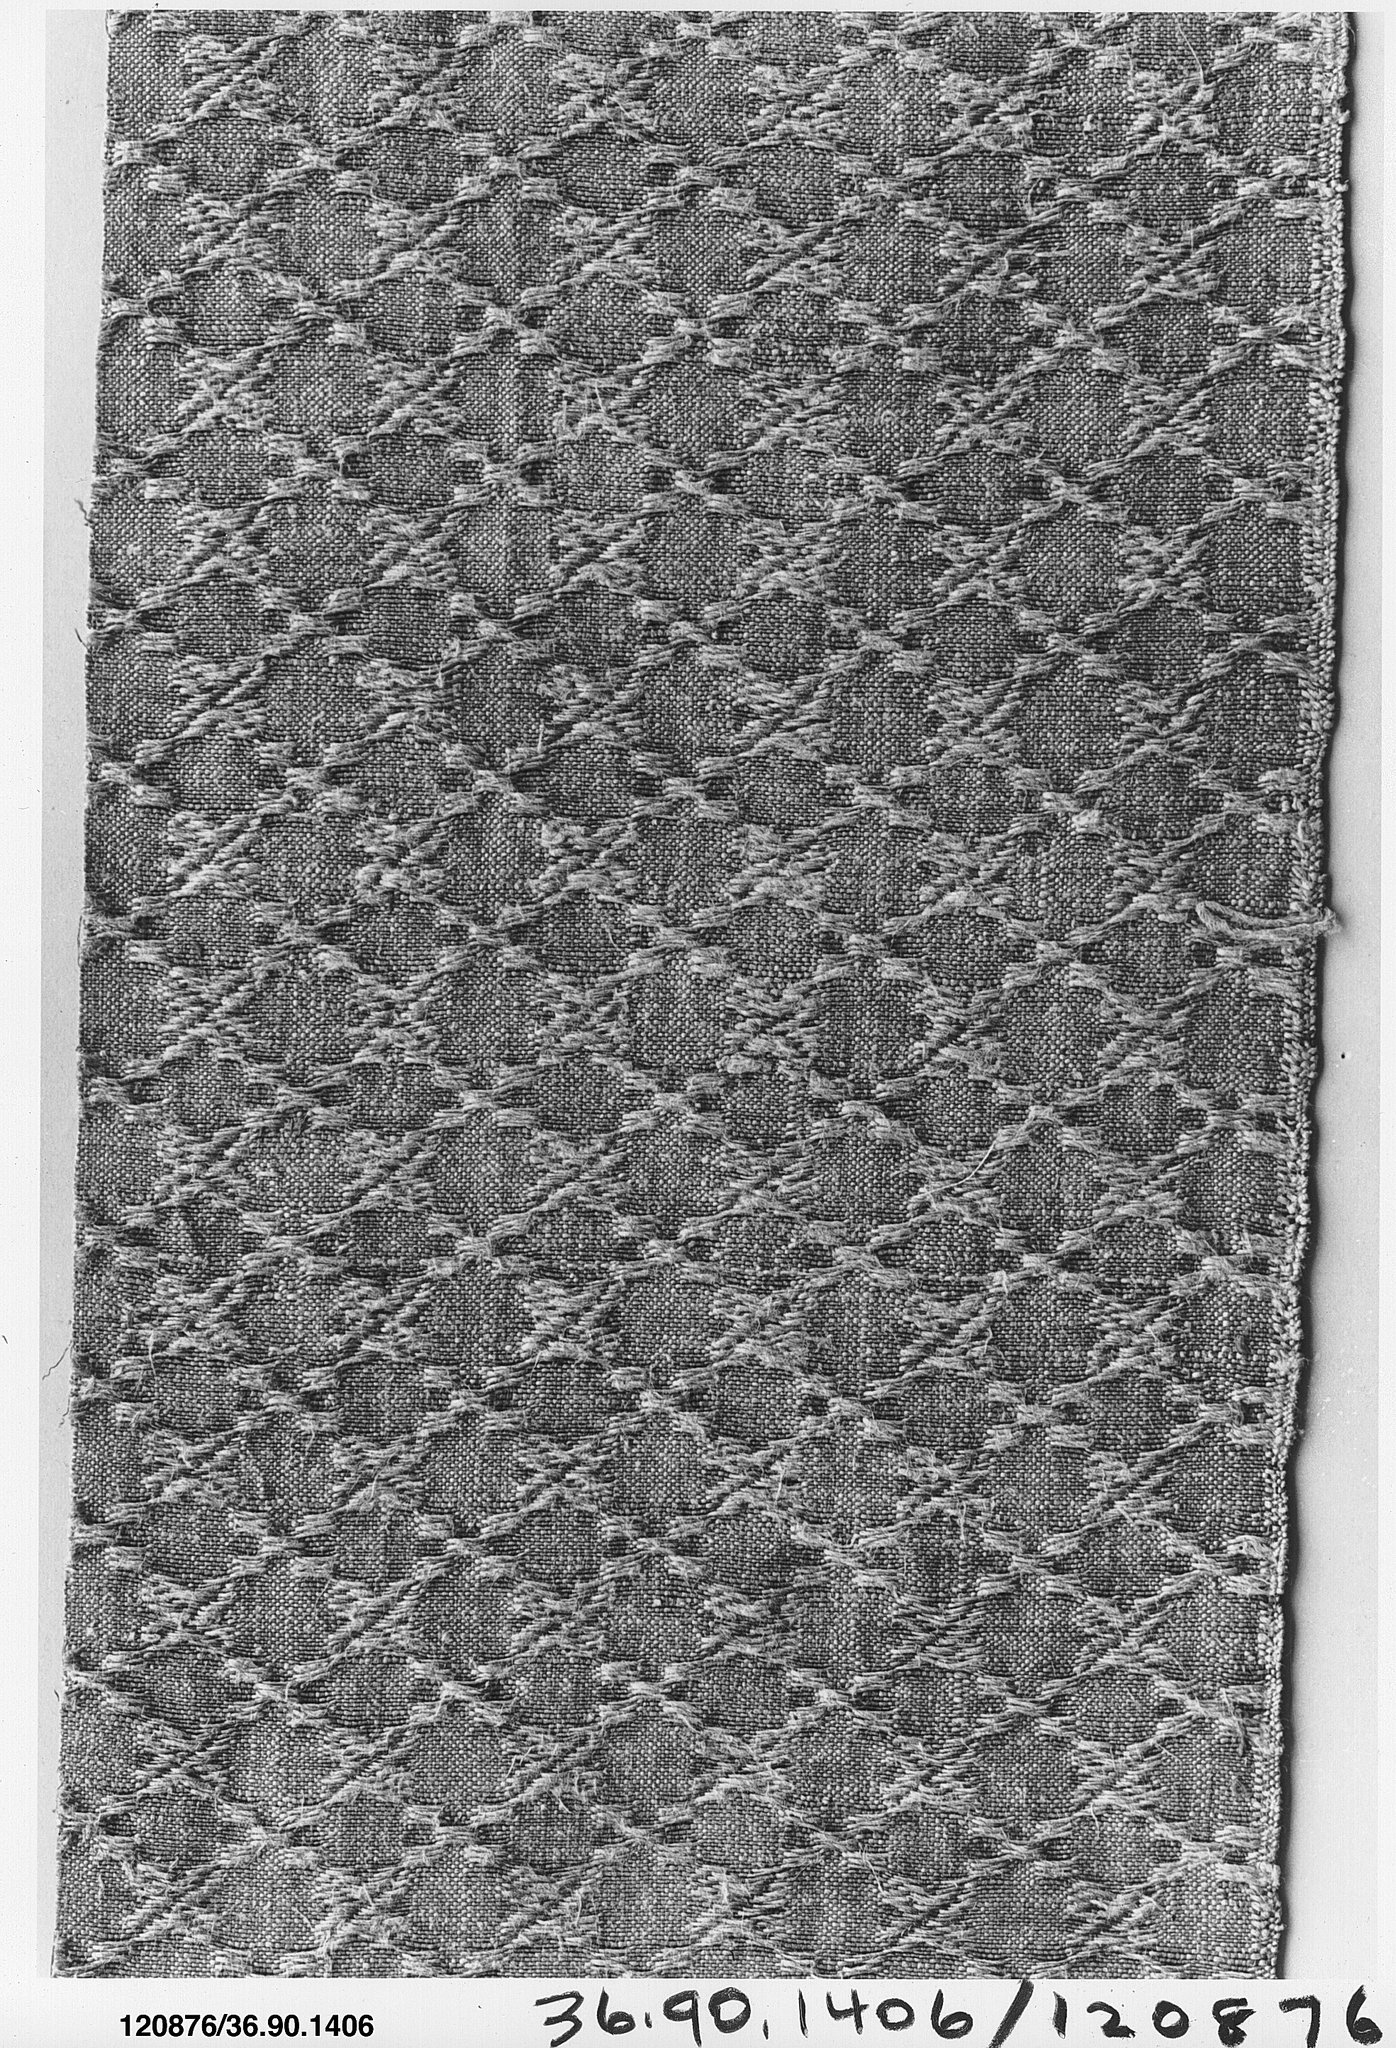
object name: piece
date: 1601-1800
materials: hemp, silk